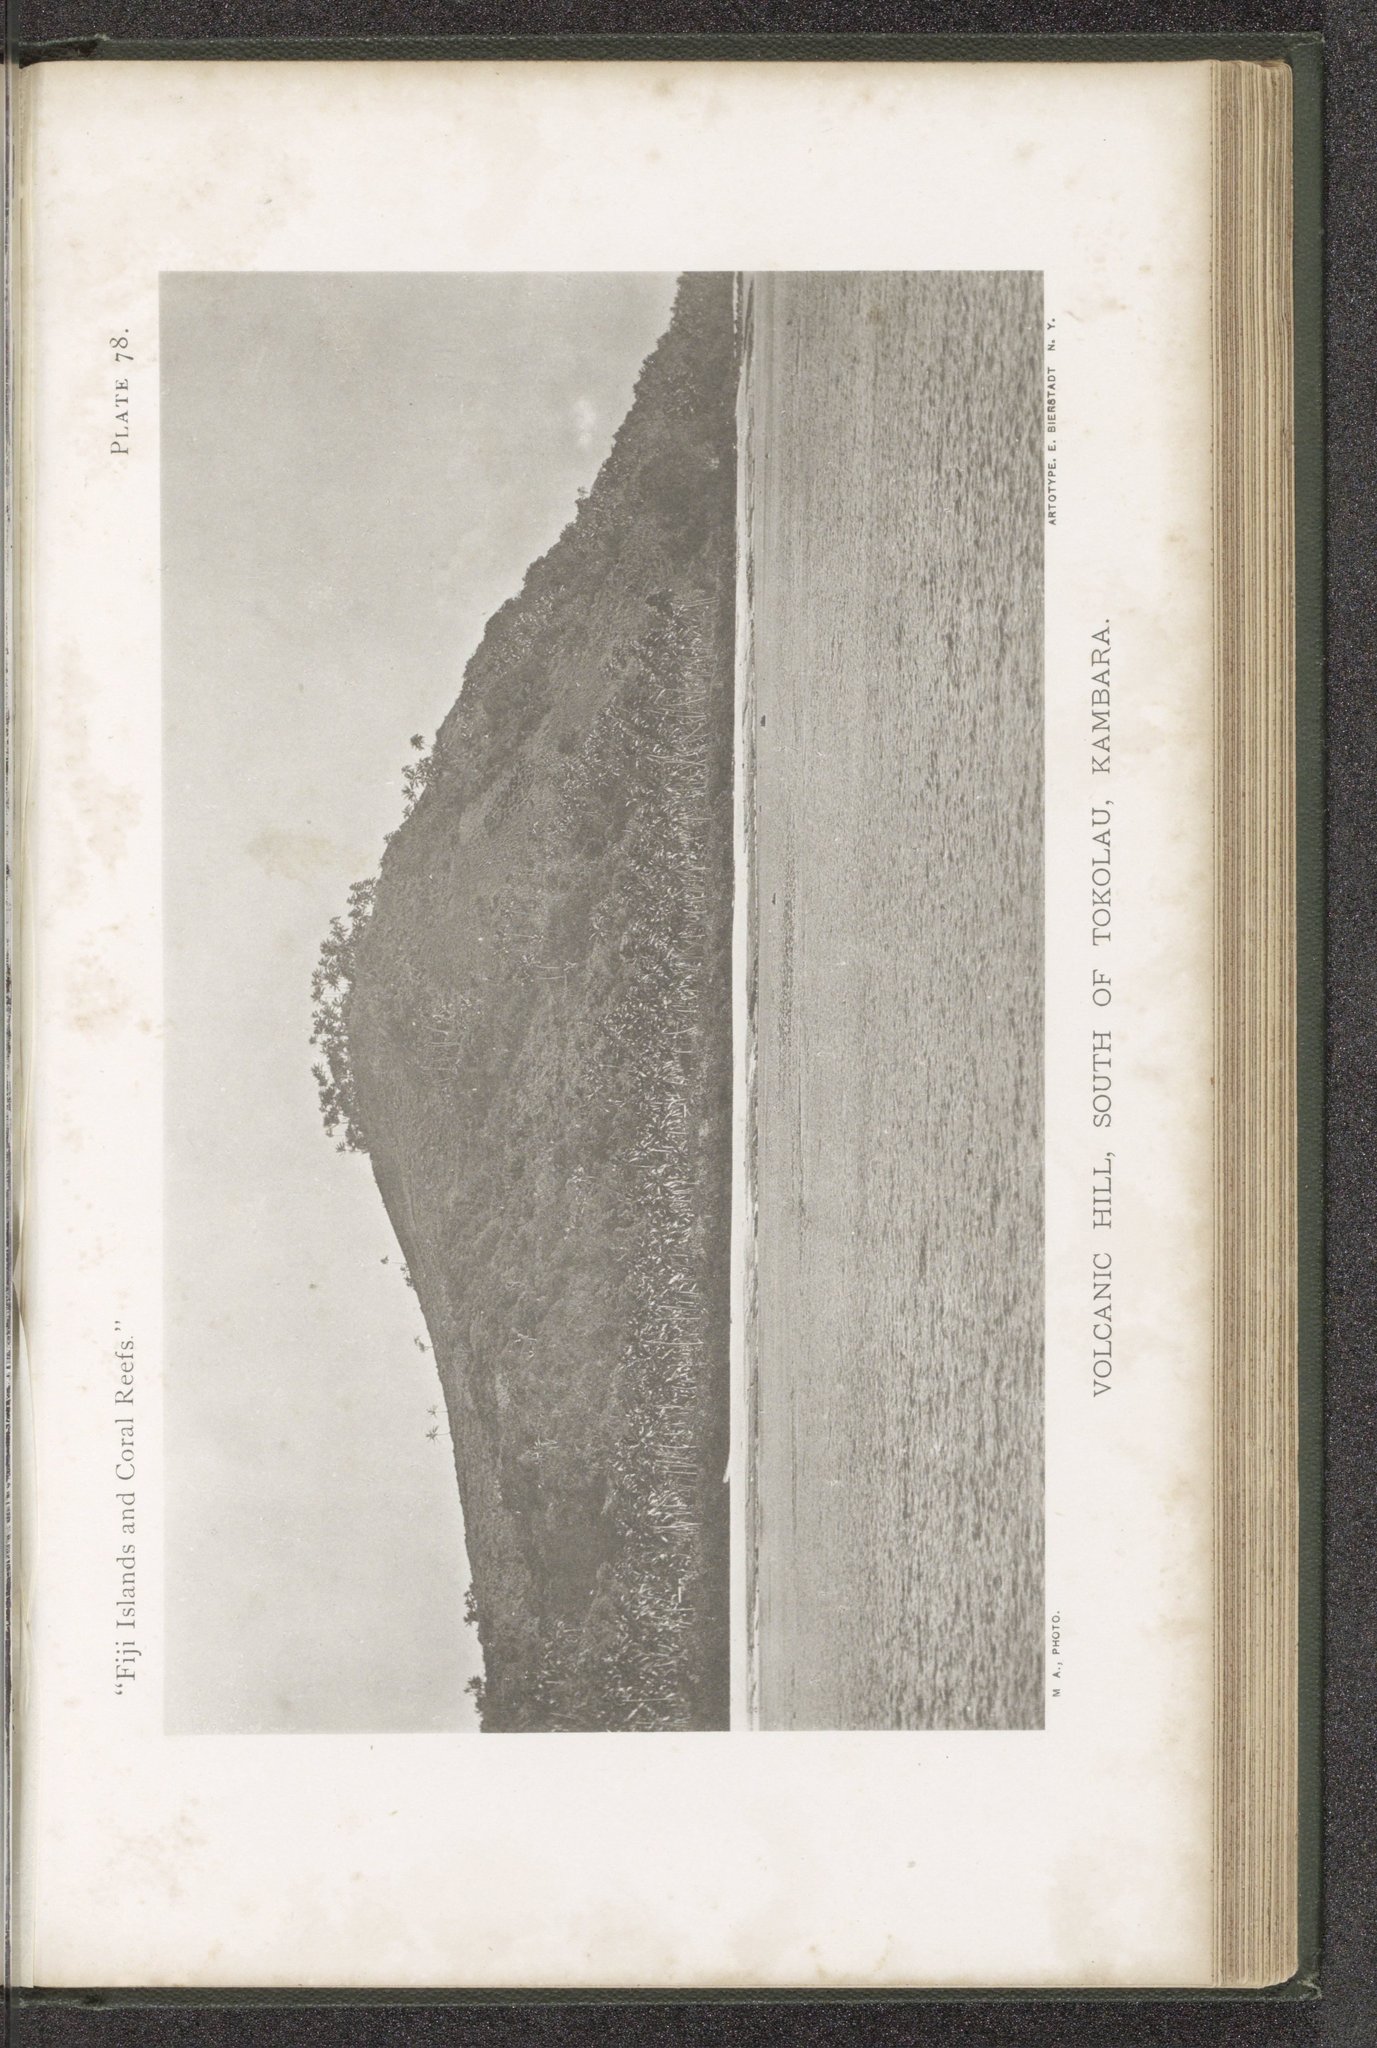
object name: photomechanical print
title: Gezicht op een vulkanische heuvel op Kabara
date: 1885-1899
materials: paper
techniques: photograph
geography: new york city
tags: island, volcanic formations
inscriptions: number: ‘Plate 78.’, name: ‘M. A., Photo.’, name: ‘Artotype. E. Bierstadt N. Y.’